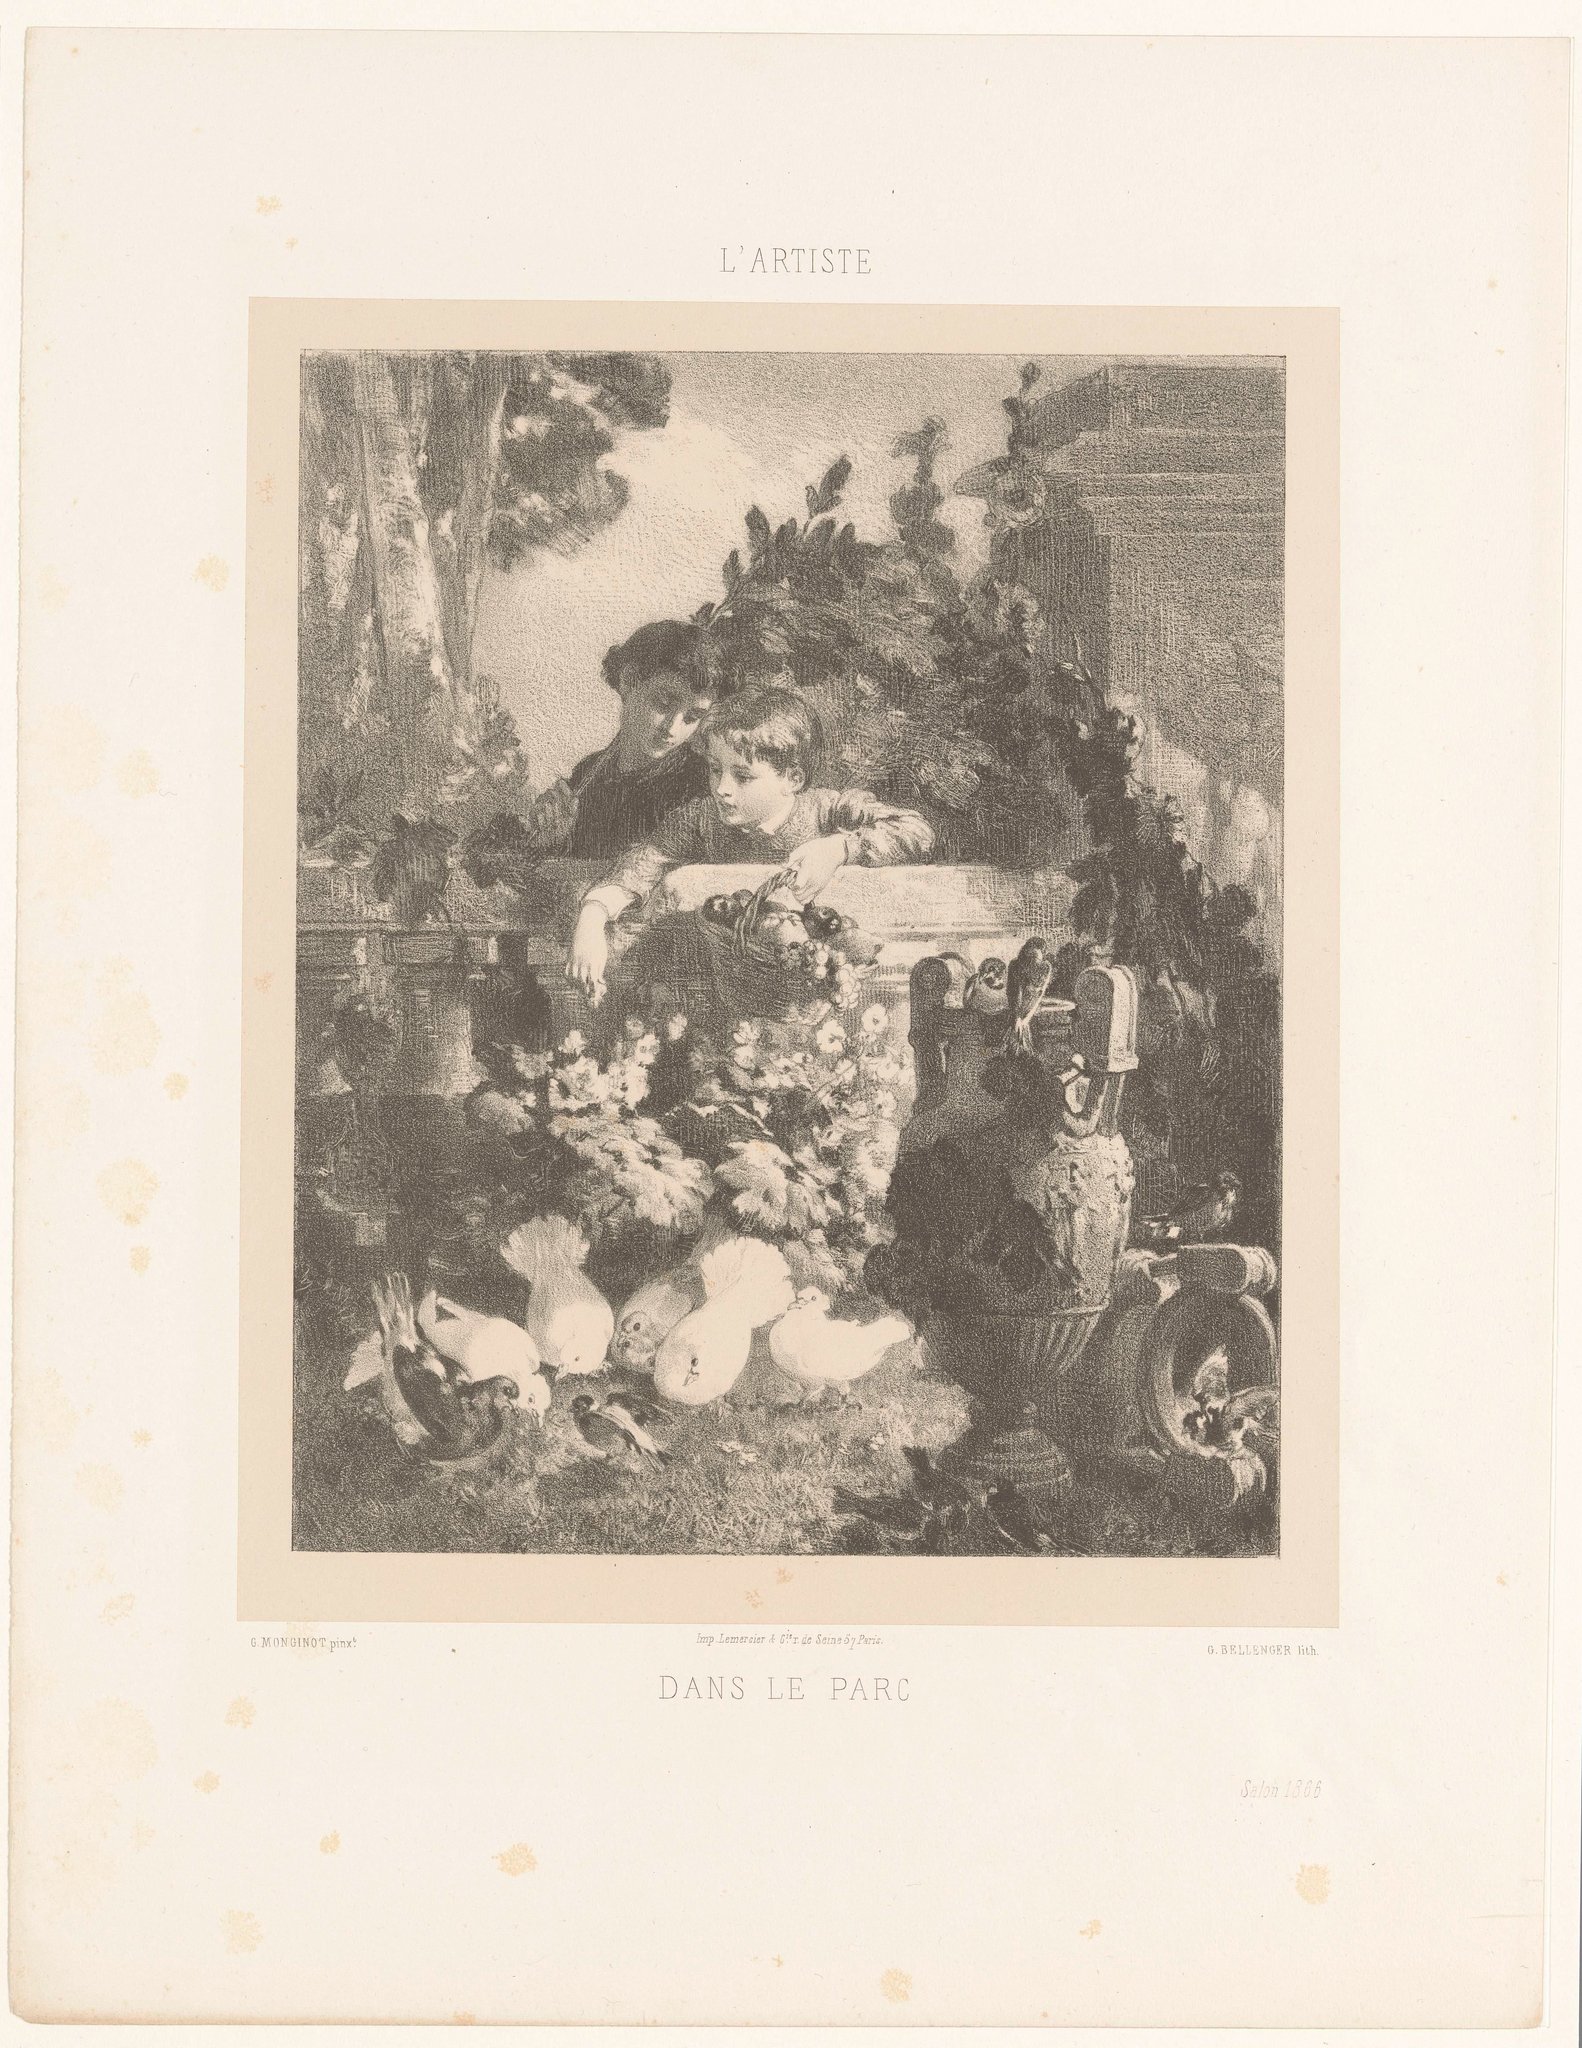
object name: print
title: Twee kinderen met duiven in een park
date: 1866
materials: paper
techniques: lithograph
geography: paris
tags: park, child, child and nature (games and plays), doves, pigeons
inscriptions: collector's mark: Lugt 2228a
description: Prent gepubliceerd in 'L'Artiste, journal de la littérature et des beaux-arts', een geïllustreerd weekblad dat verscheen tussen 1831 en 1904.